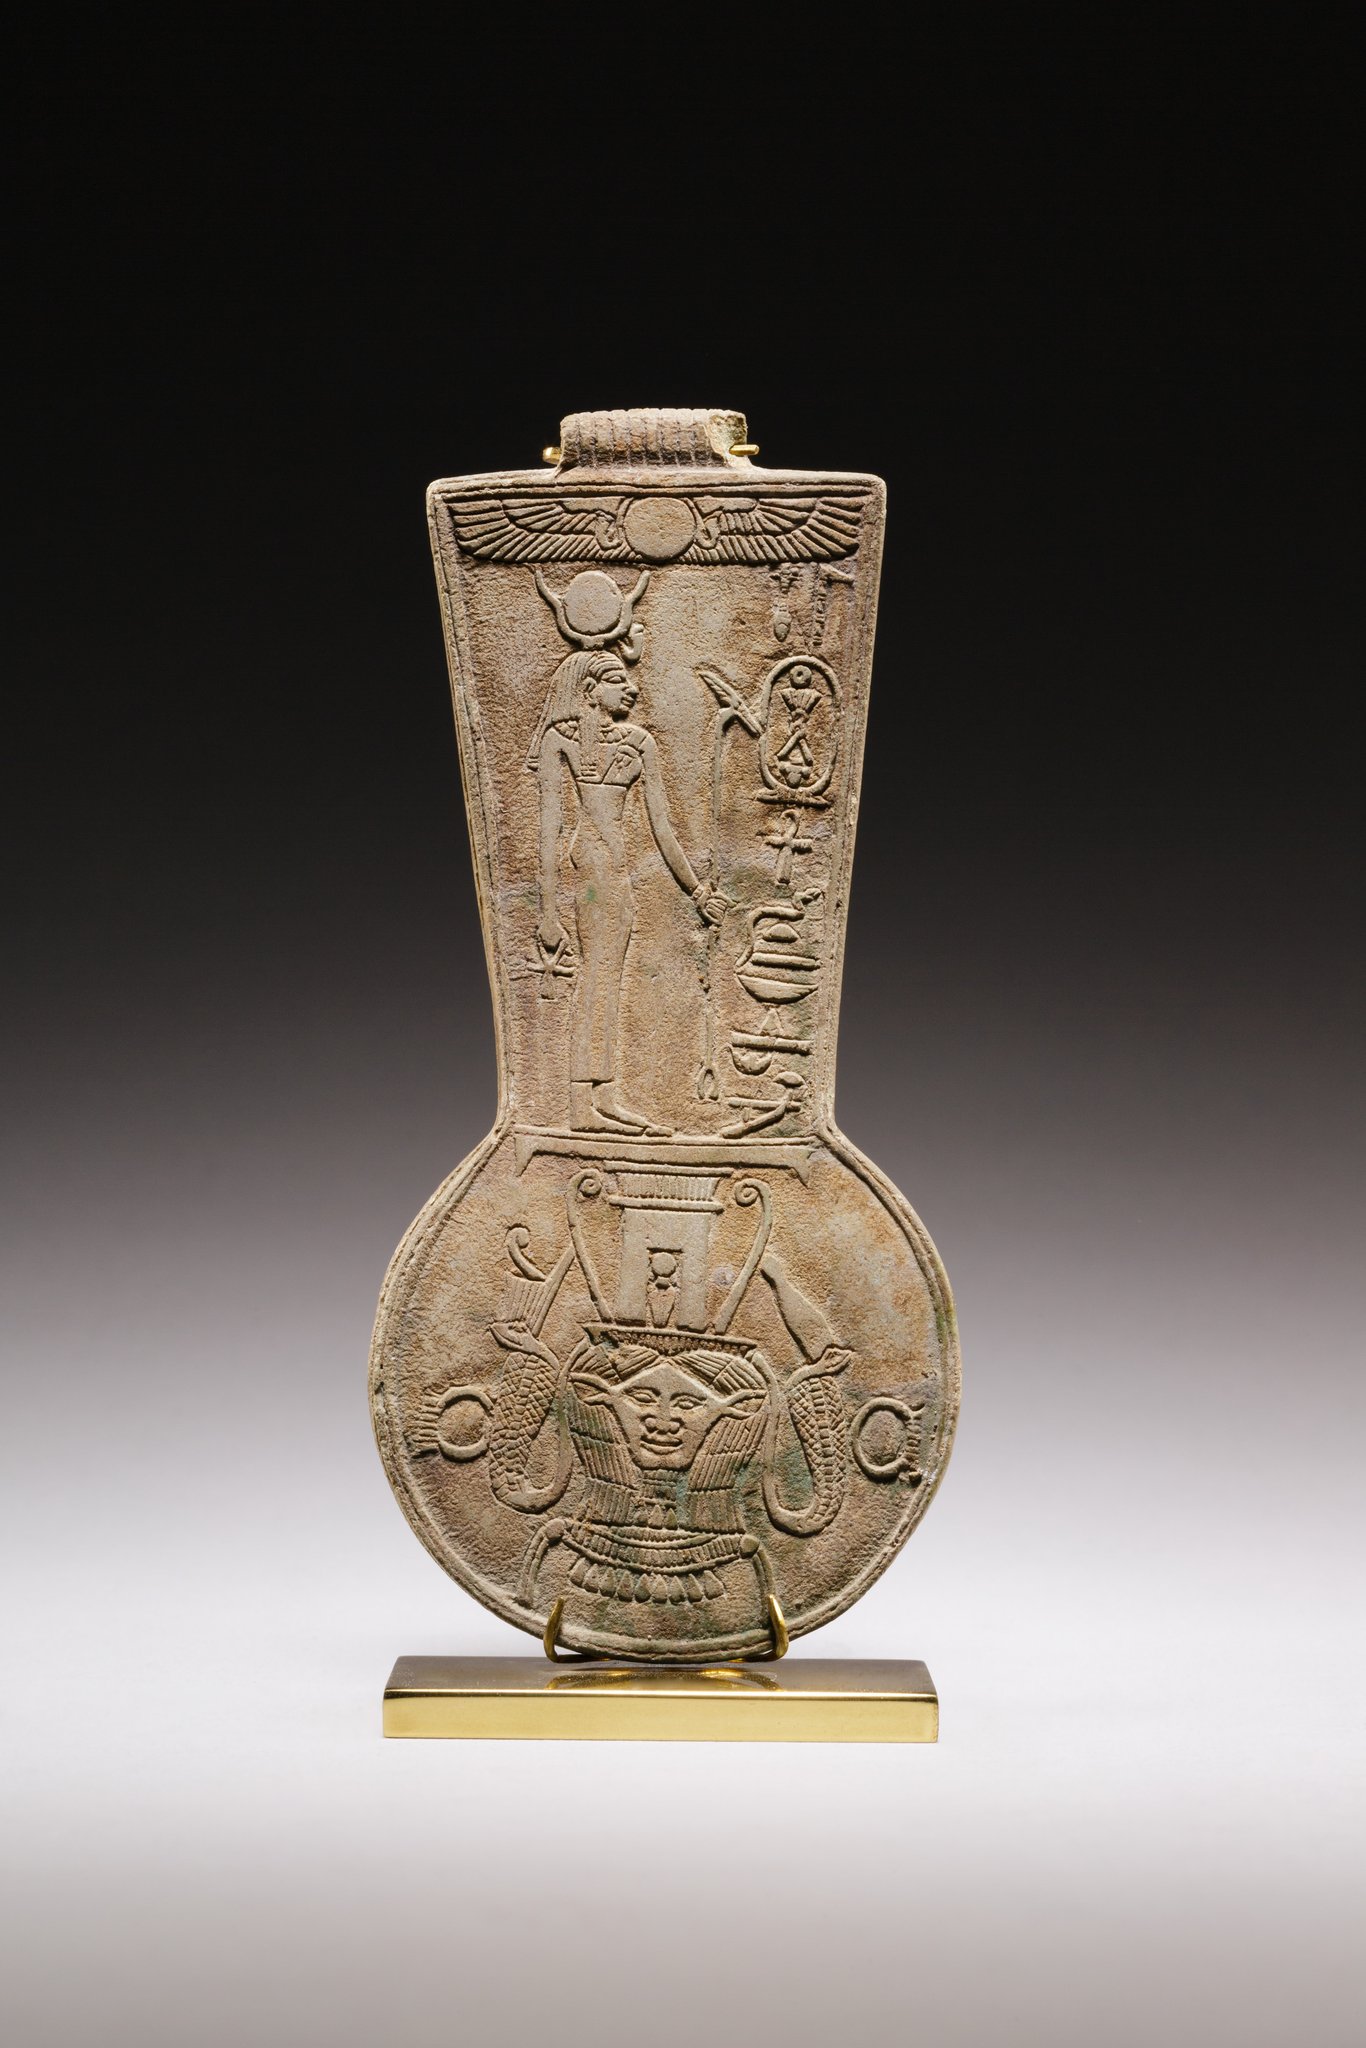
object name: menat, wahibre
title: Menat with royal name Wahibre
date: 664-525 BCE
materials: faience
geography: egypt